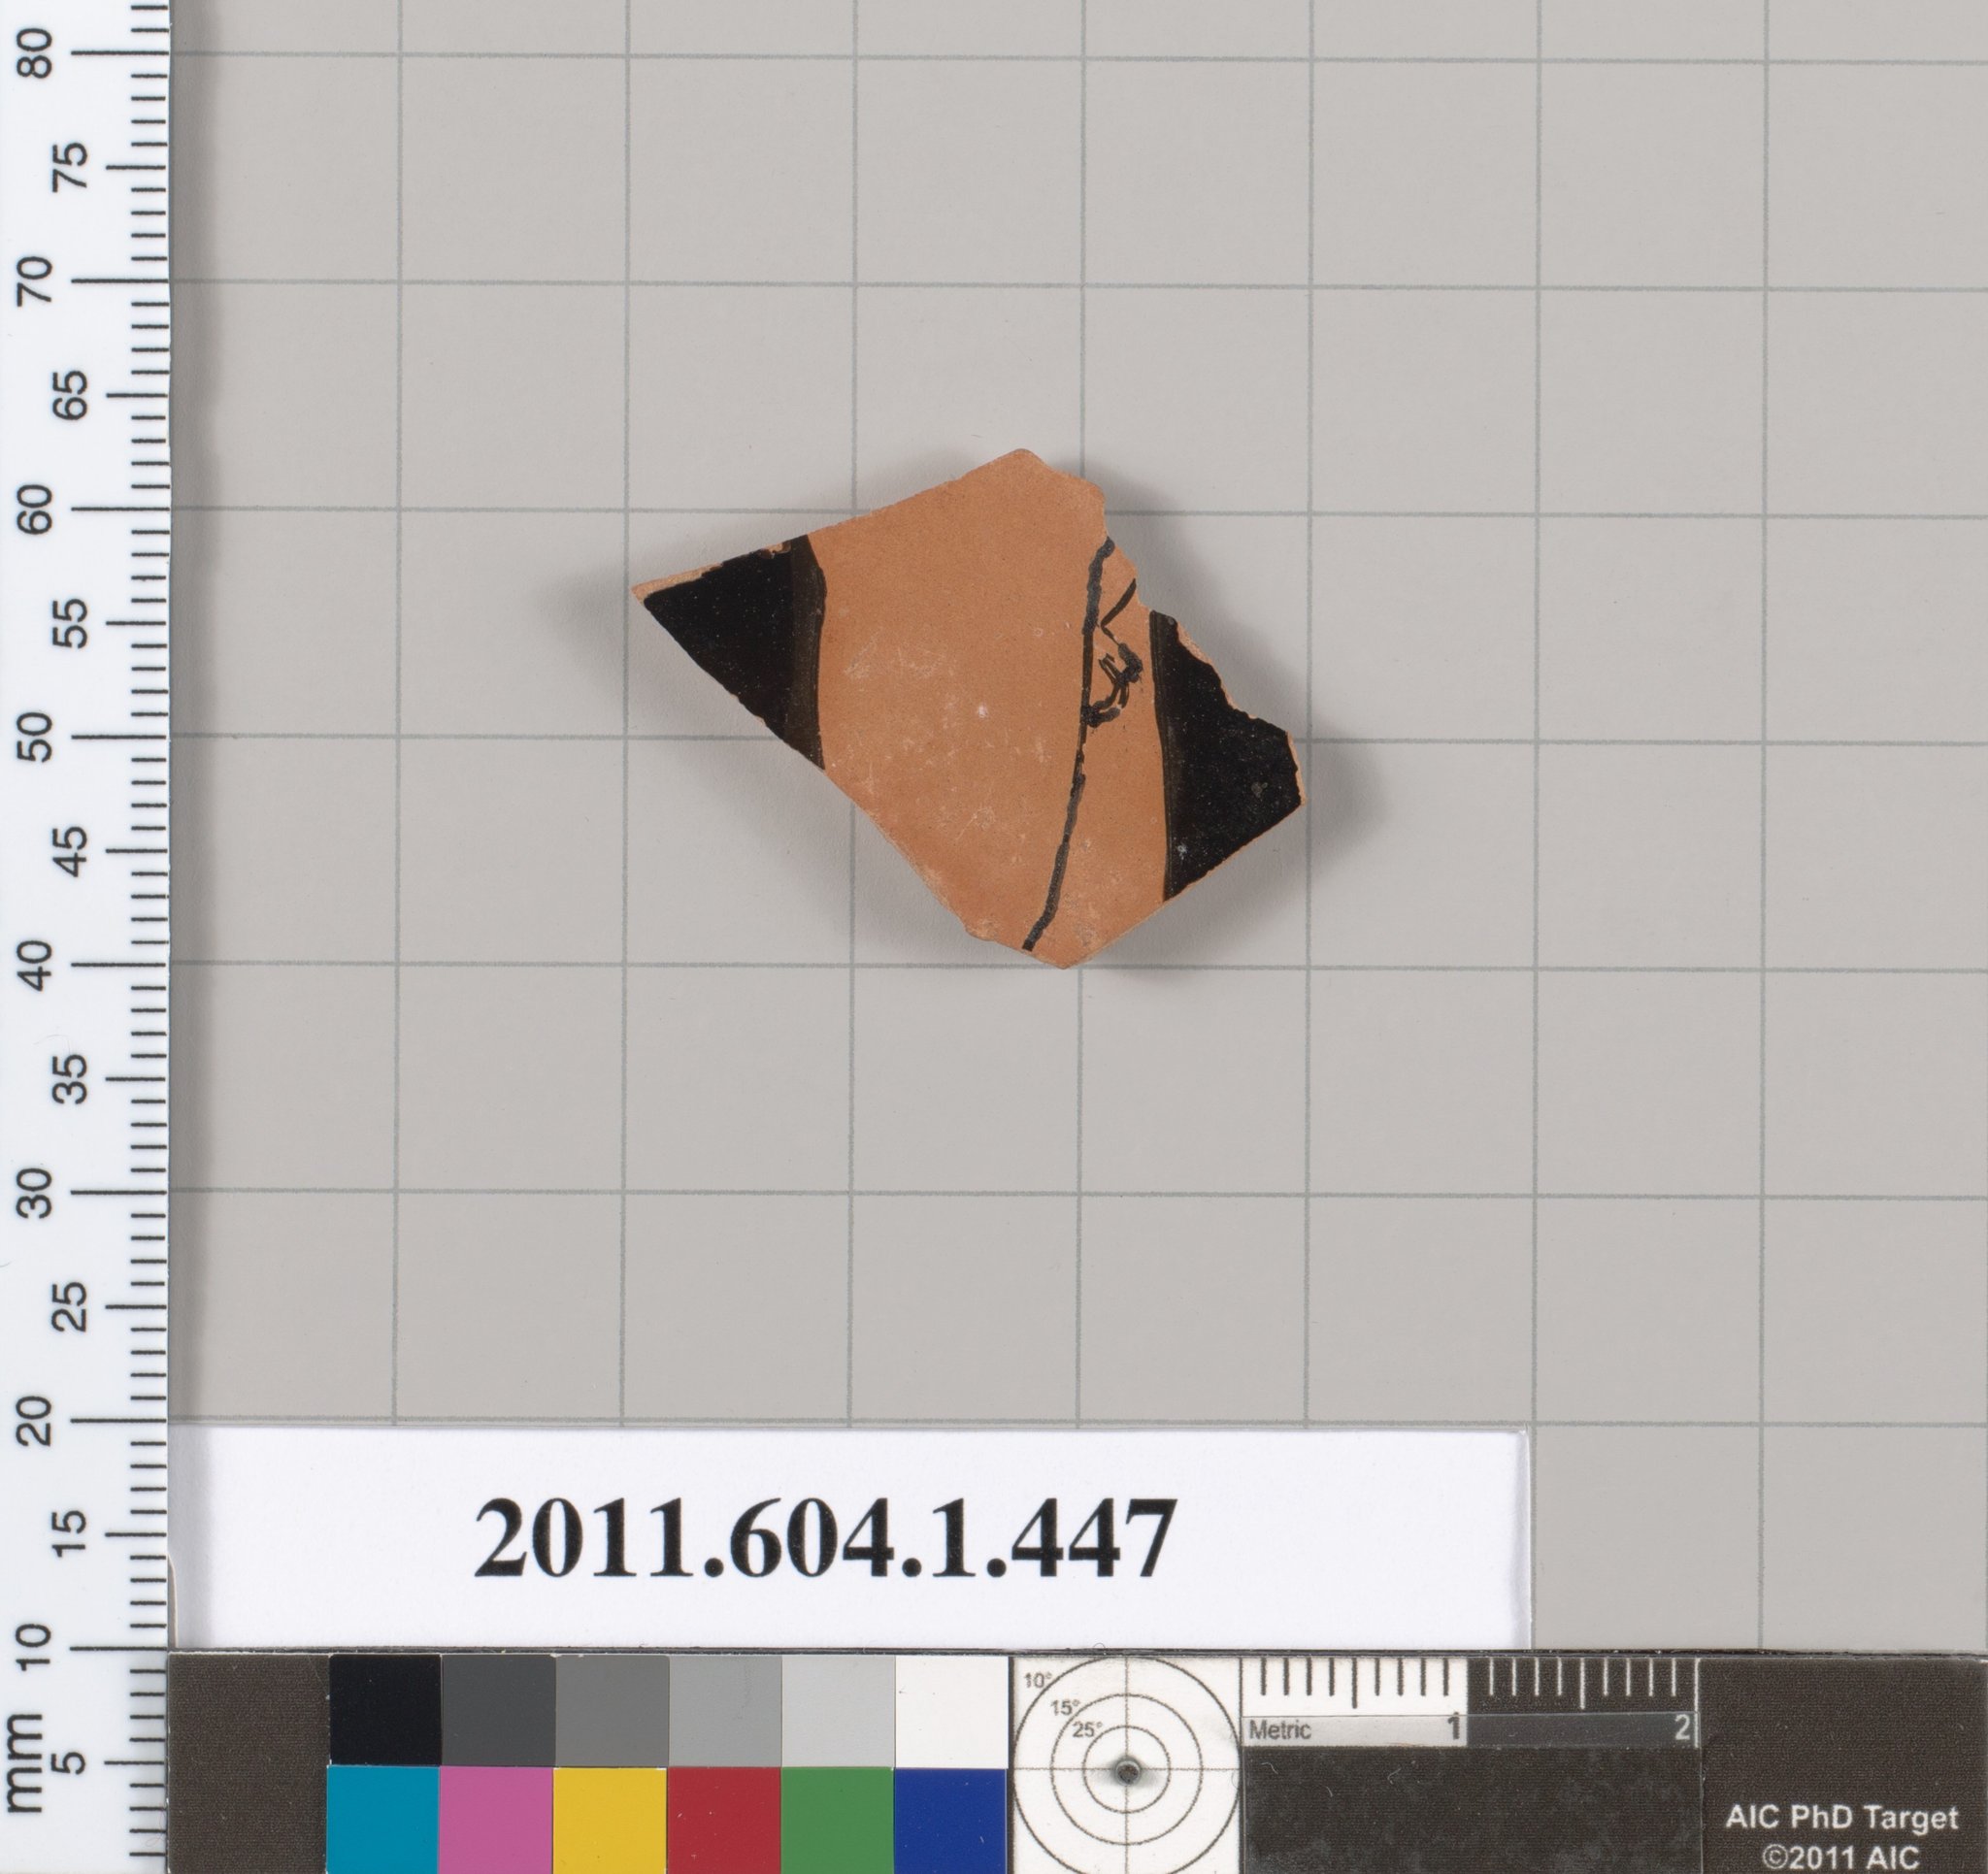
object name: kylix fragment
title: Terracotta fragment of a kylix (drinking cup)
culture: greek, attic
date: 475-451 BCE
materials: terracotta